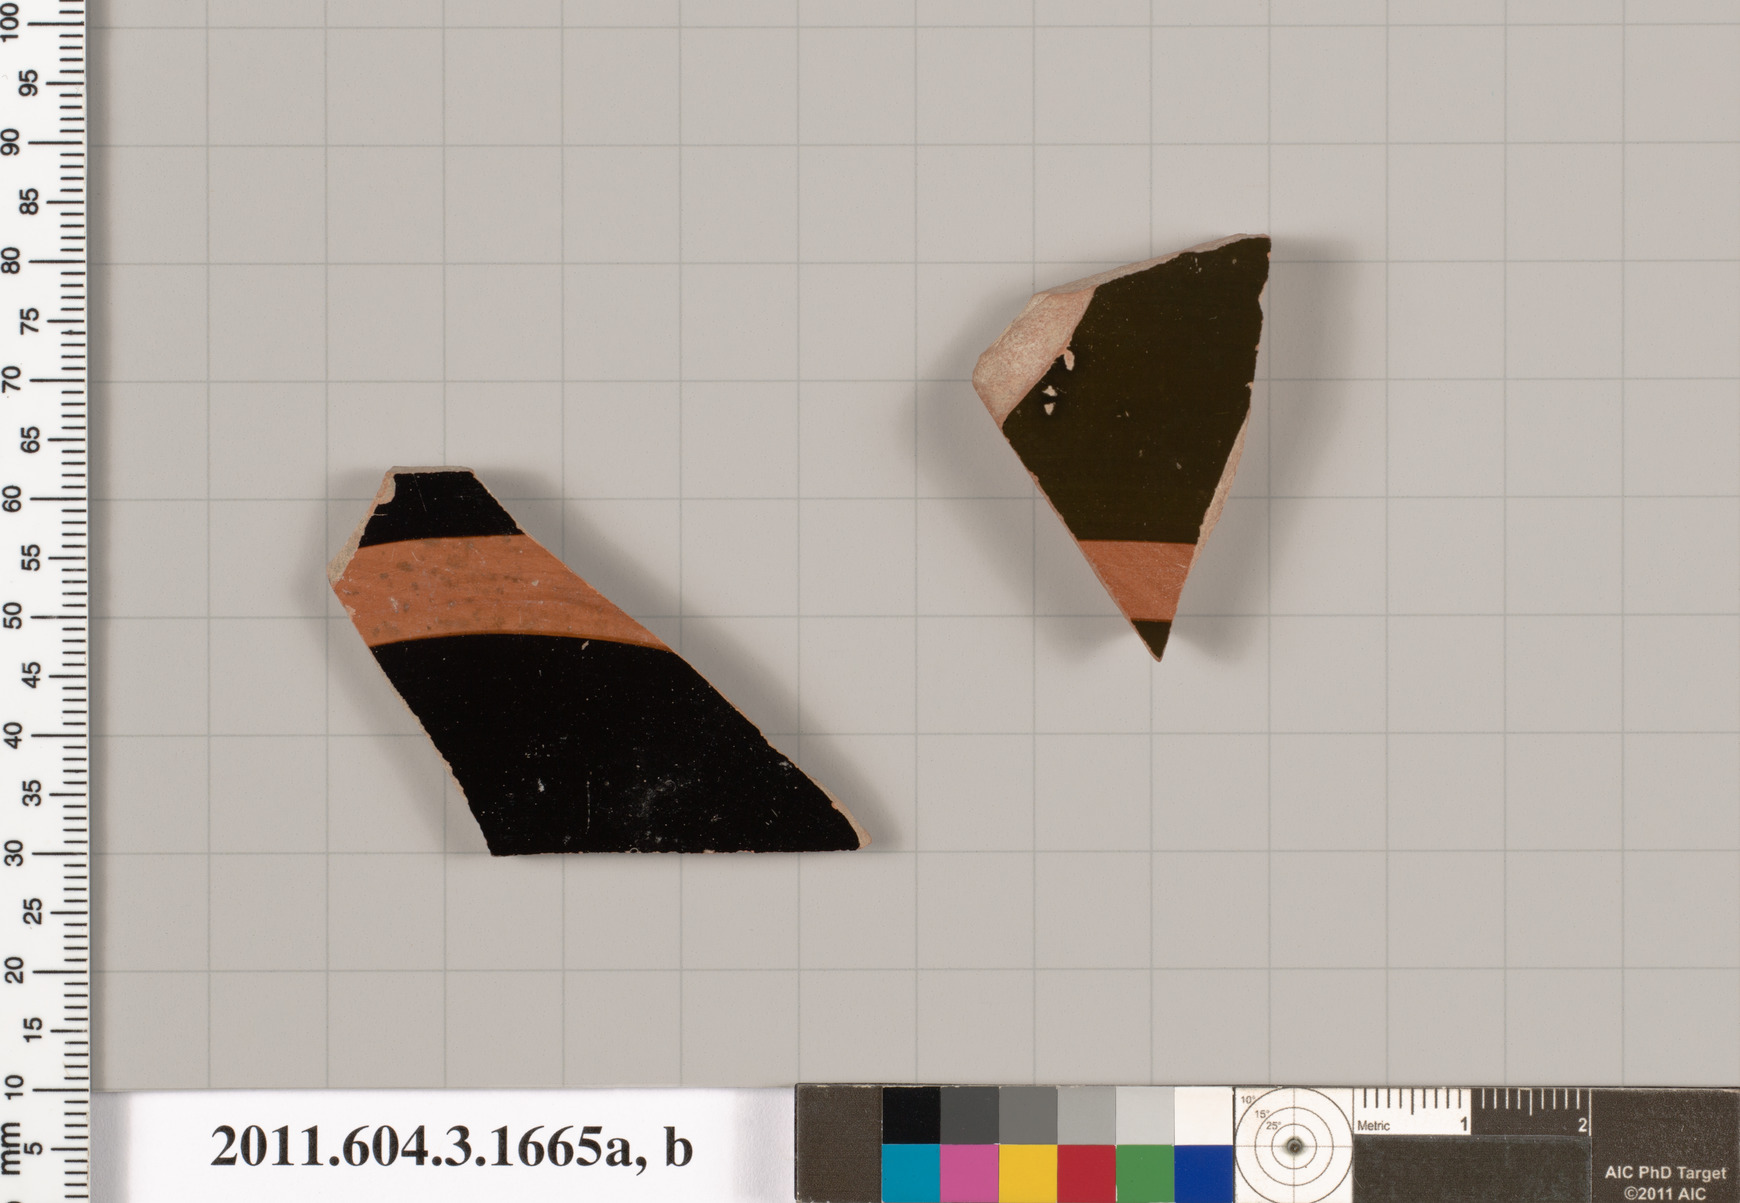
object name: kylix fragment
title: Terracotta fragments of kylikes: Band or lip cups (drinking cups)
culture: greek, attic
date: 550-526 BCE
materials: terracotta